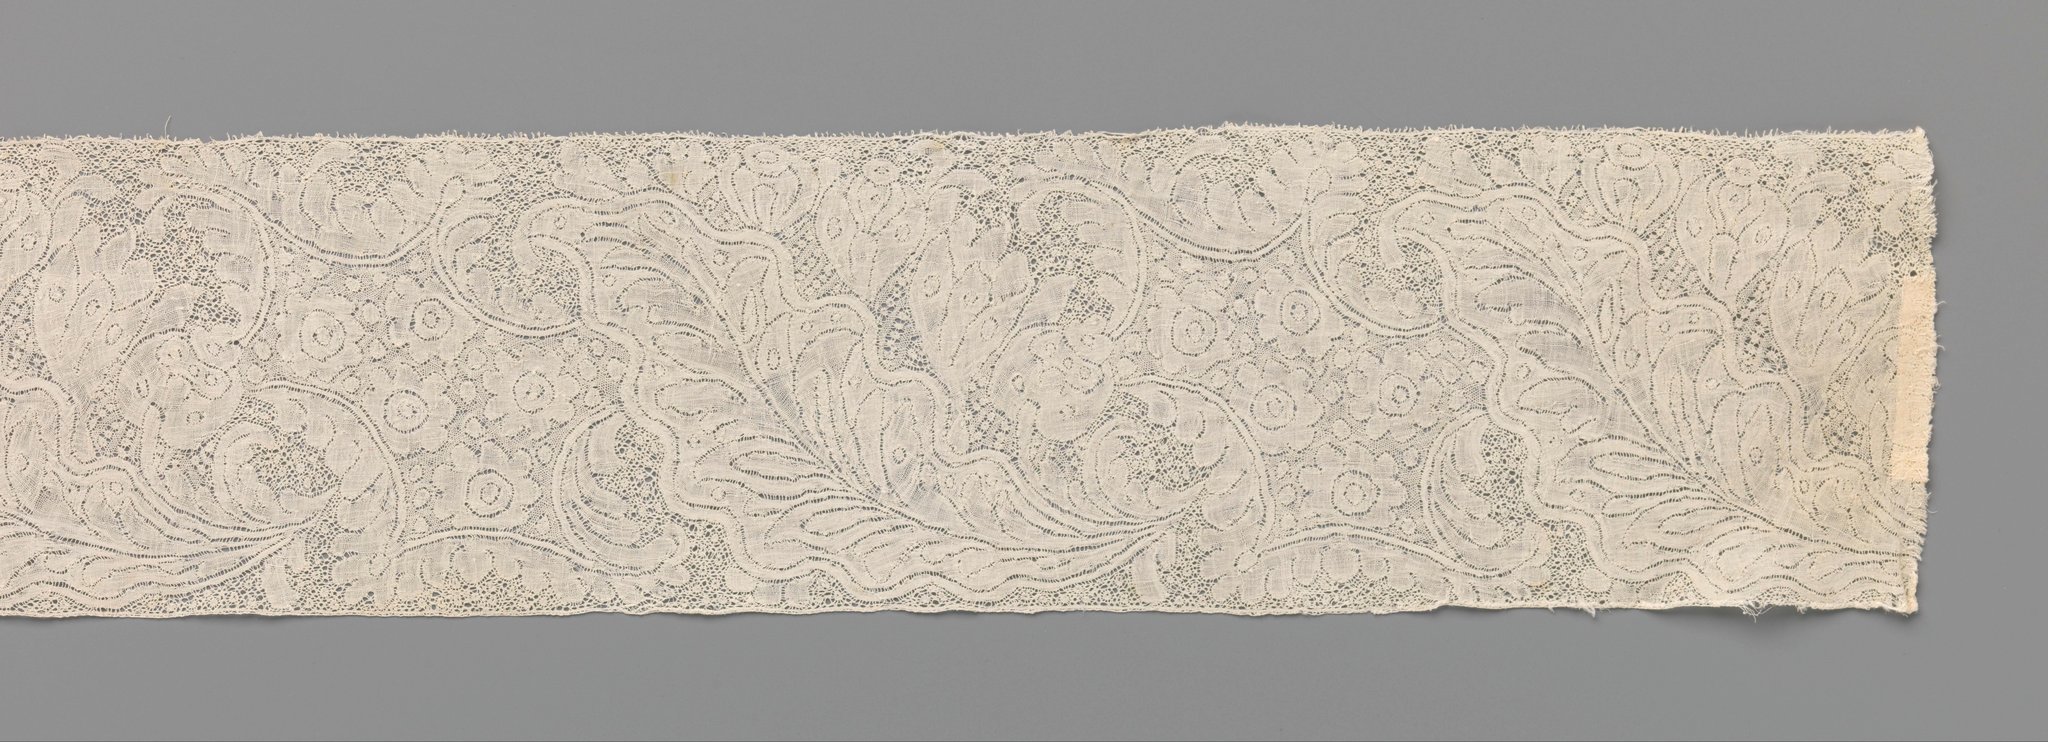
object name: strip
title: Strook kloskant met schuin geplaatste bladeren en zevenpuntige cartouches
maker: Anonymous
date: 1715-1725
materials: linen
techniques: lace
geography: southern netherlands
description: Strook naturelkleurige kloskant, Binche-kant. Het zich herhalende patroon bestaat uit een strookbreedte vullend, schuin geplaatst blad met golvende rand, waaronder een rij kelkbloemen hangt. Parallel hieraan staat een zevenpuntig cartouche, door bladeren omlijst en gevuld met rozetten. De motieven staan tegen elkaar aan en overlappen elkaar gedeeltelijk. Waar ze elkaar niet raken, zijn ze met elkaar verbonden door een fijne siergrond, een sneeuwvlokkengrond. De motieven zijn gemaakt in linnenslag met opengewerkte randjes en netslagvullingen. De boven- en onderzijde van de strook zijn recht afgewerkt, waarbij de onderzijde is voorzien van picots.